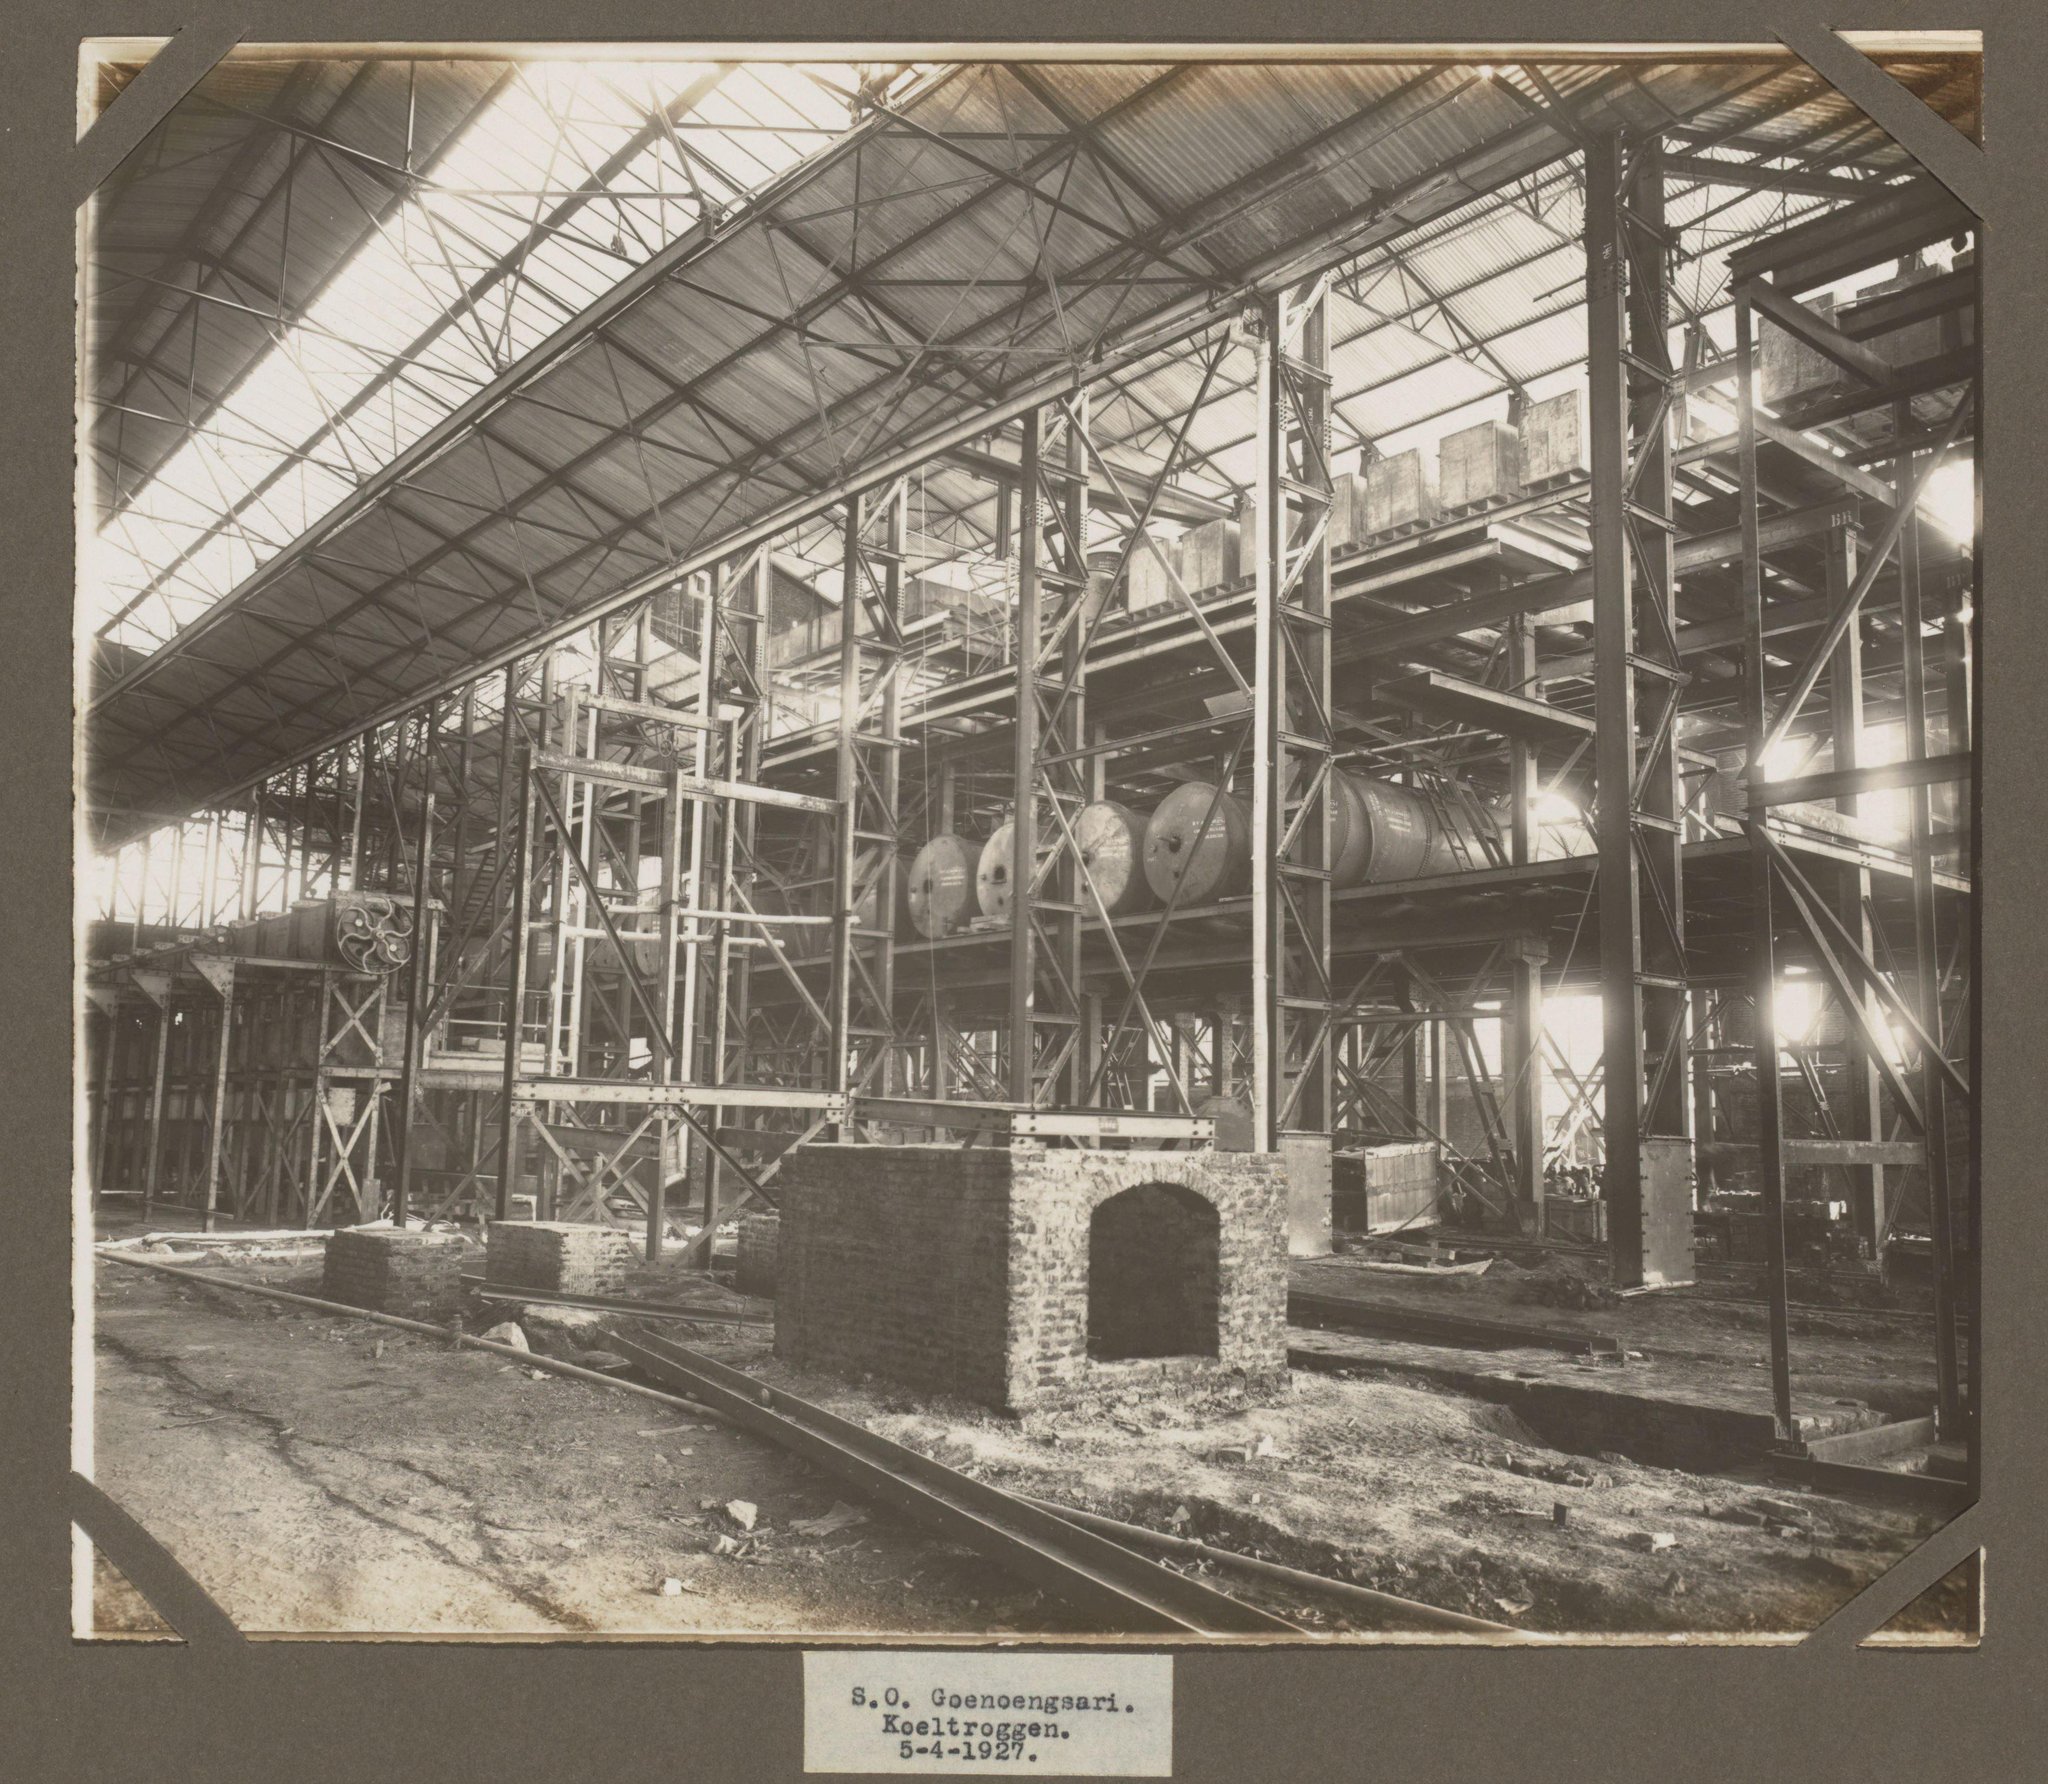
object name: photograph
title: S.O. Goenoengsari. Koeltroggen. 5-4-1927.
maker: Anonymous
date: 1904-1927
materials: photographic support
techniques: gelatin silver print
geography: east java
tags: colonial system, trade-company, factory-interior, machine shop, making the overground structures (~ building activities), (non-fruit) products of plants or trees: sugarcane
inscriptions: inscription: ‘S.O. Goenoengsari. Koeltroggen. 5-4-1927.’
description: Interieur van een fabrieksgebouw in aanbouw, april 1927. Onderdeel van het fotoalbum met foto's van de opbouw van de suikerfabriek te Goenoengsari op Oost-Java door de Handels Vereniging Amsterdam 1926-1927.